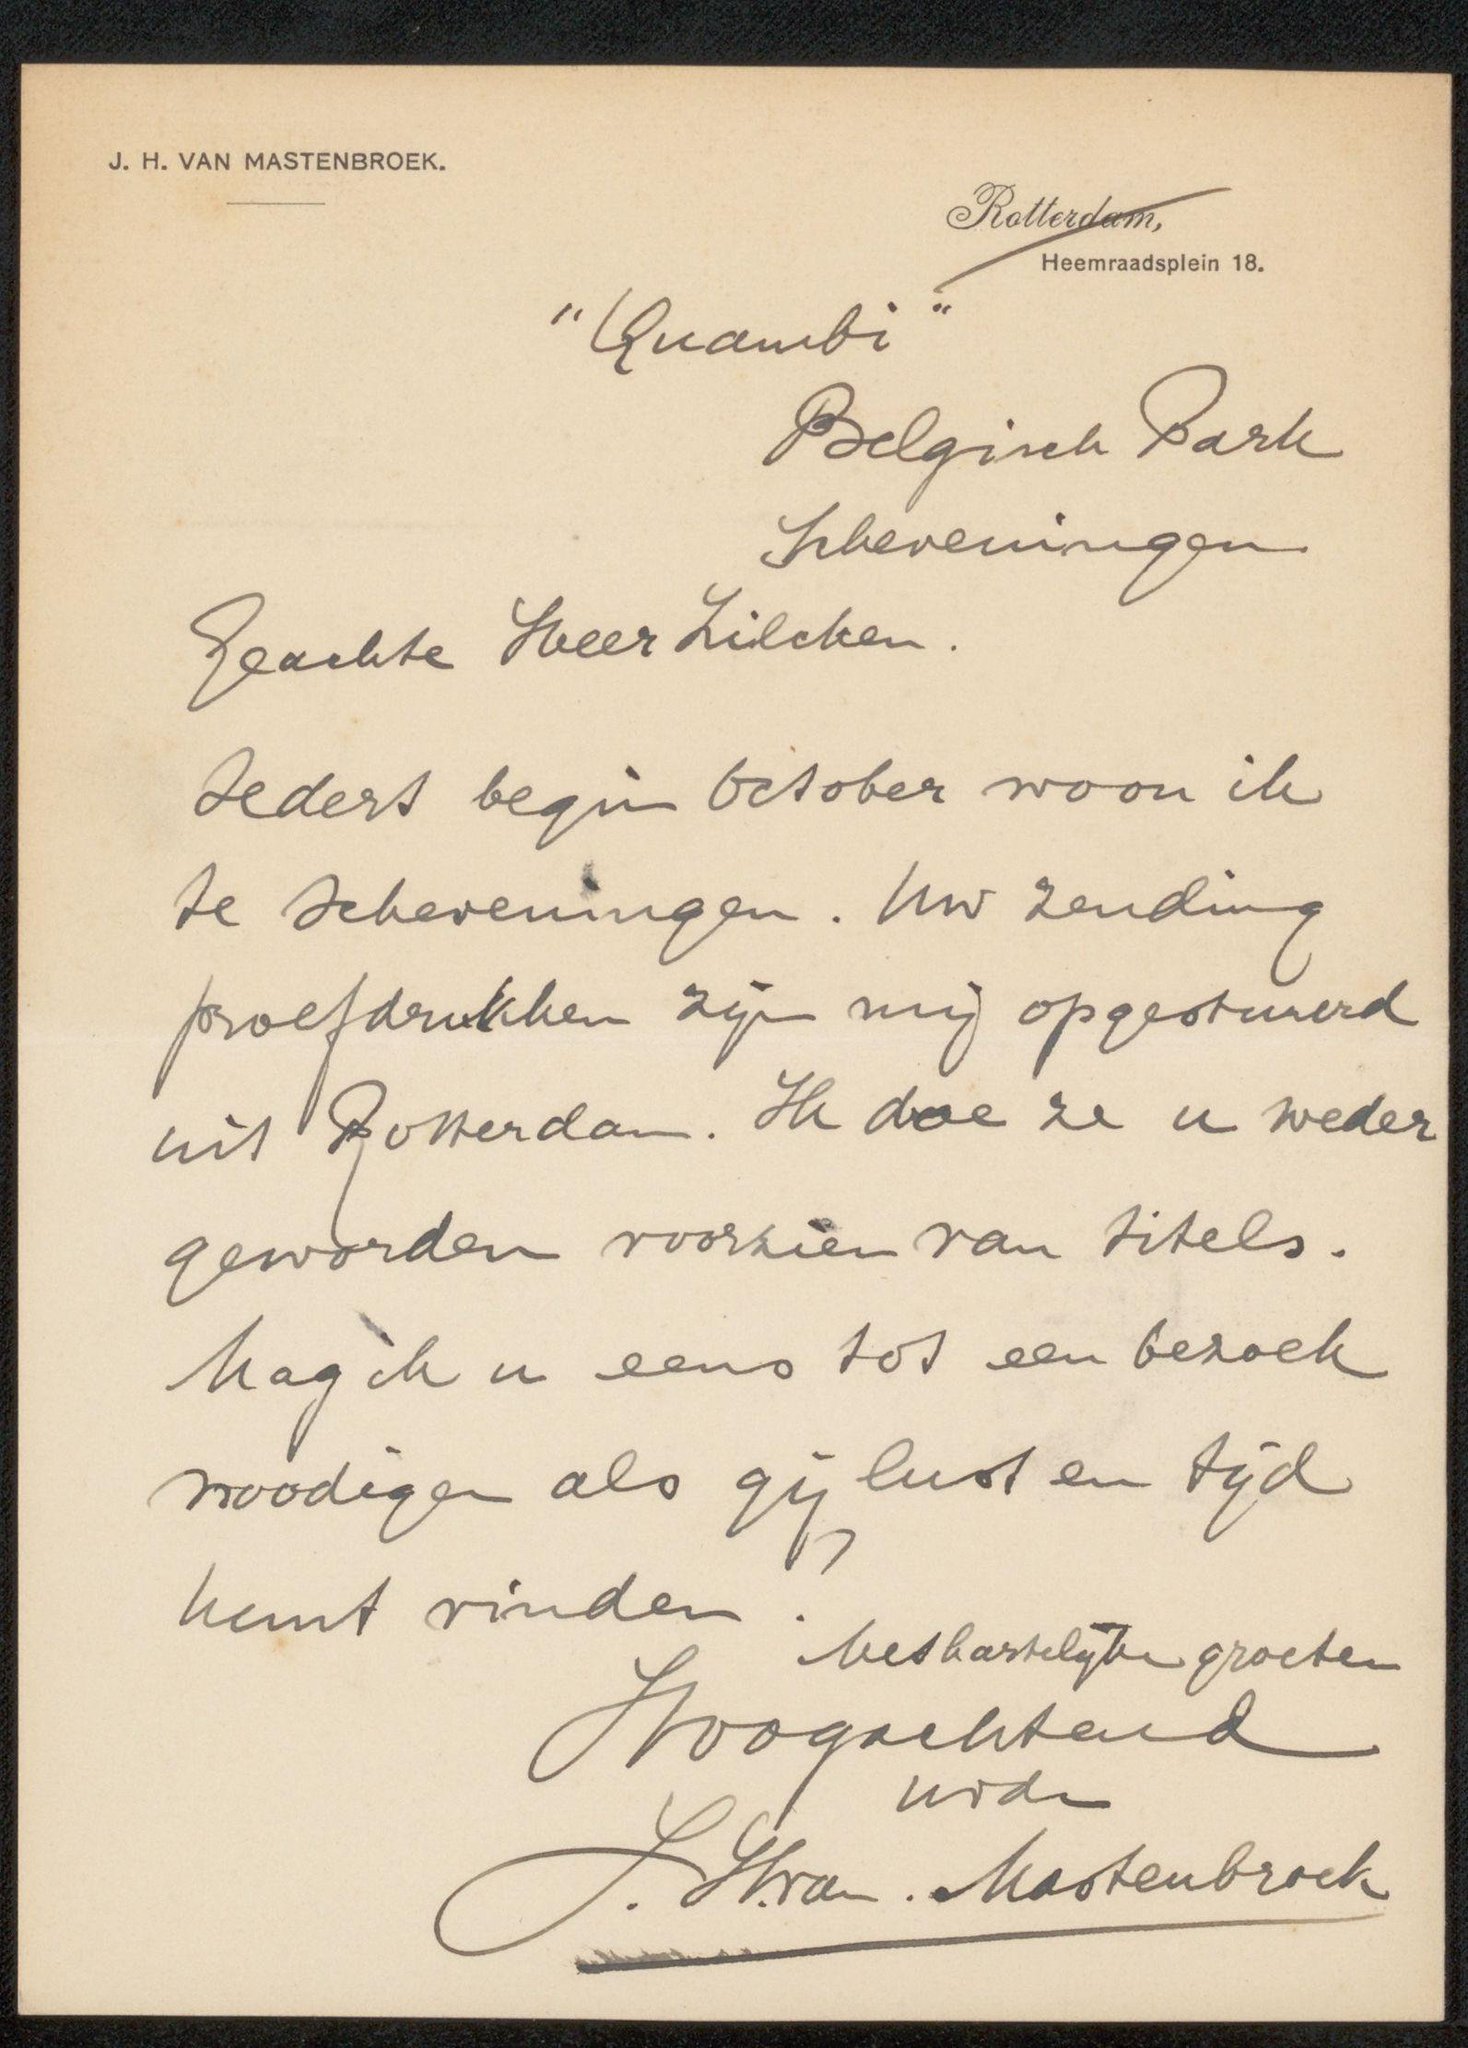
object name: letter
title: Brief aan Philip Zilcken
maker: johan hendrik van mastenbroek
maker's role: painter, print maker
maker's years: 1875-1945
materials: ink, paper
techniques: pen, writing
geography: scheveningen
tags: the hague, painter, draughtsman, philip zilcken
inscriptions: name: ‘J. H. VAN MASTENBROEK.’, collector's mark: ‘RPK’